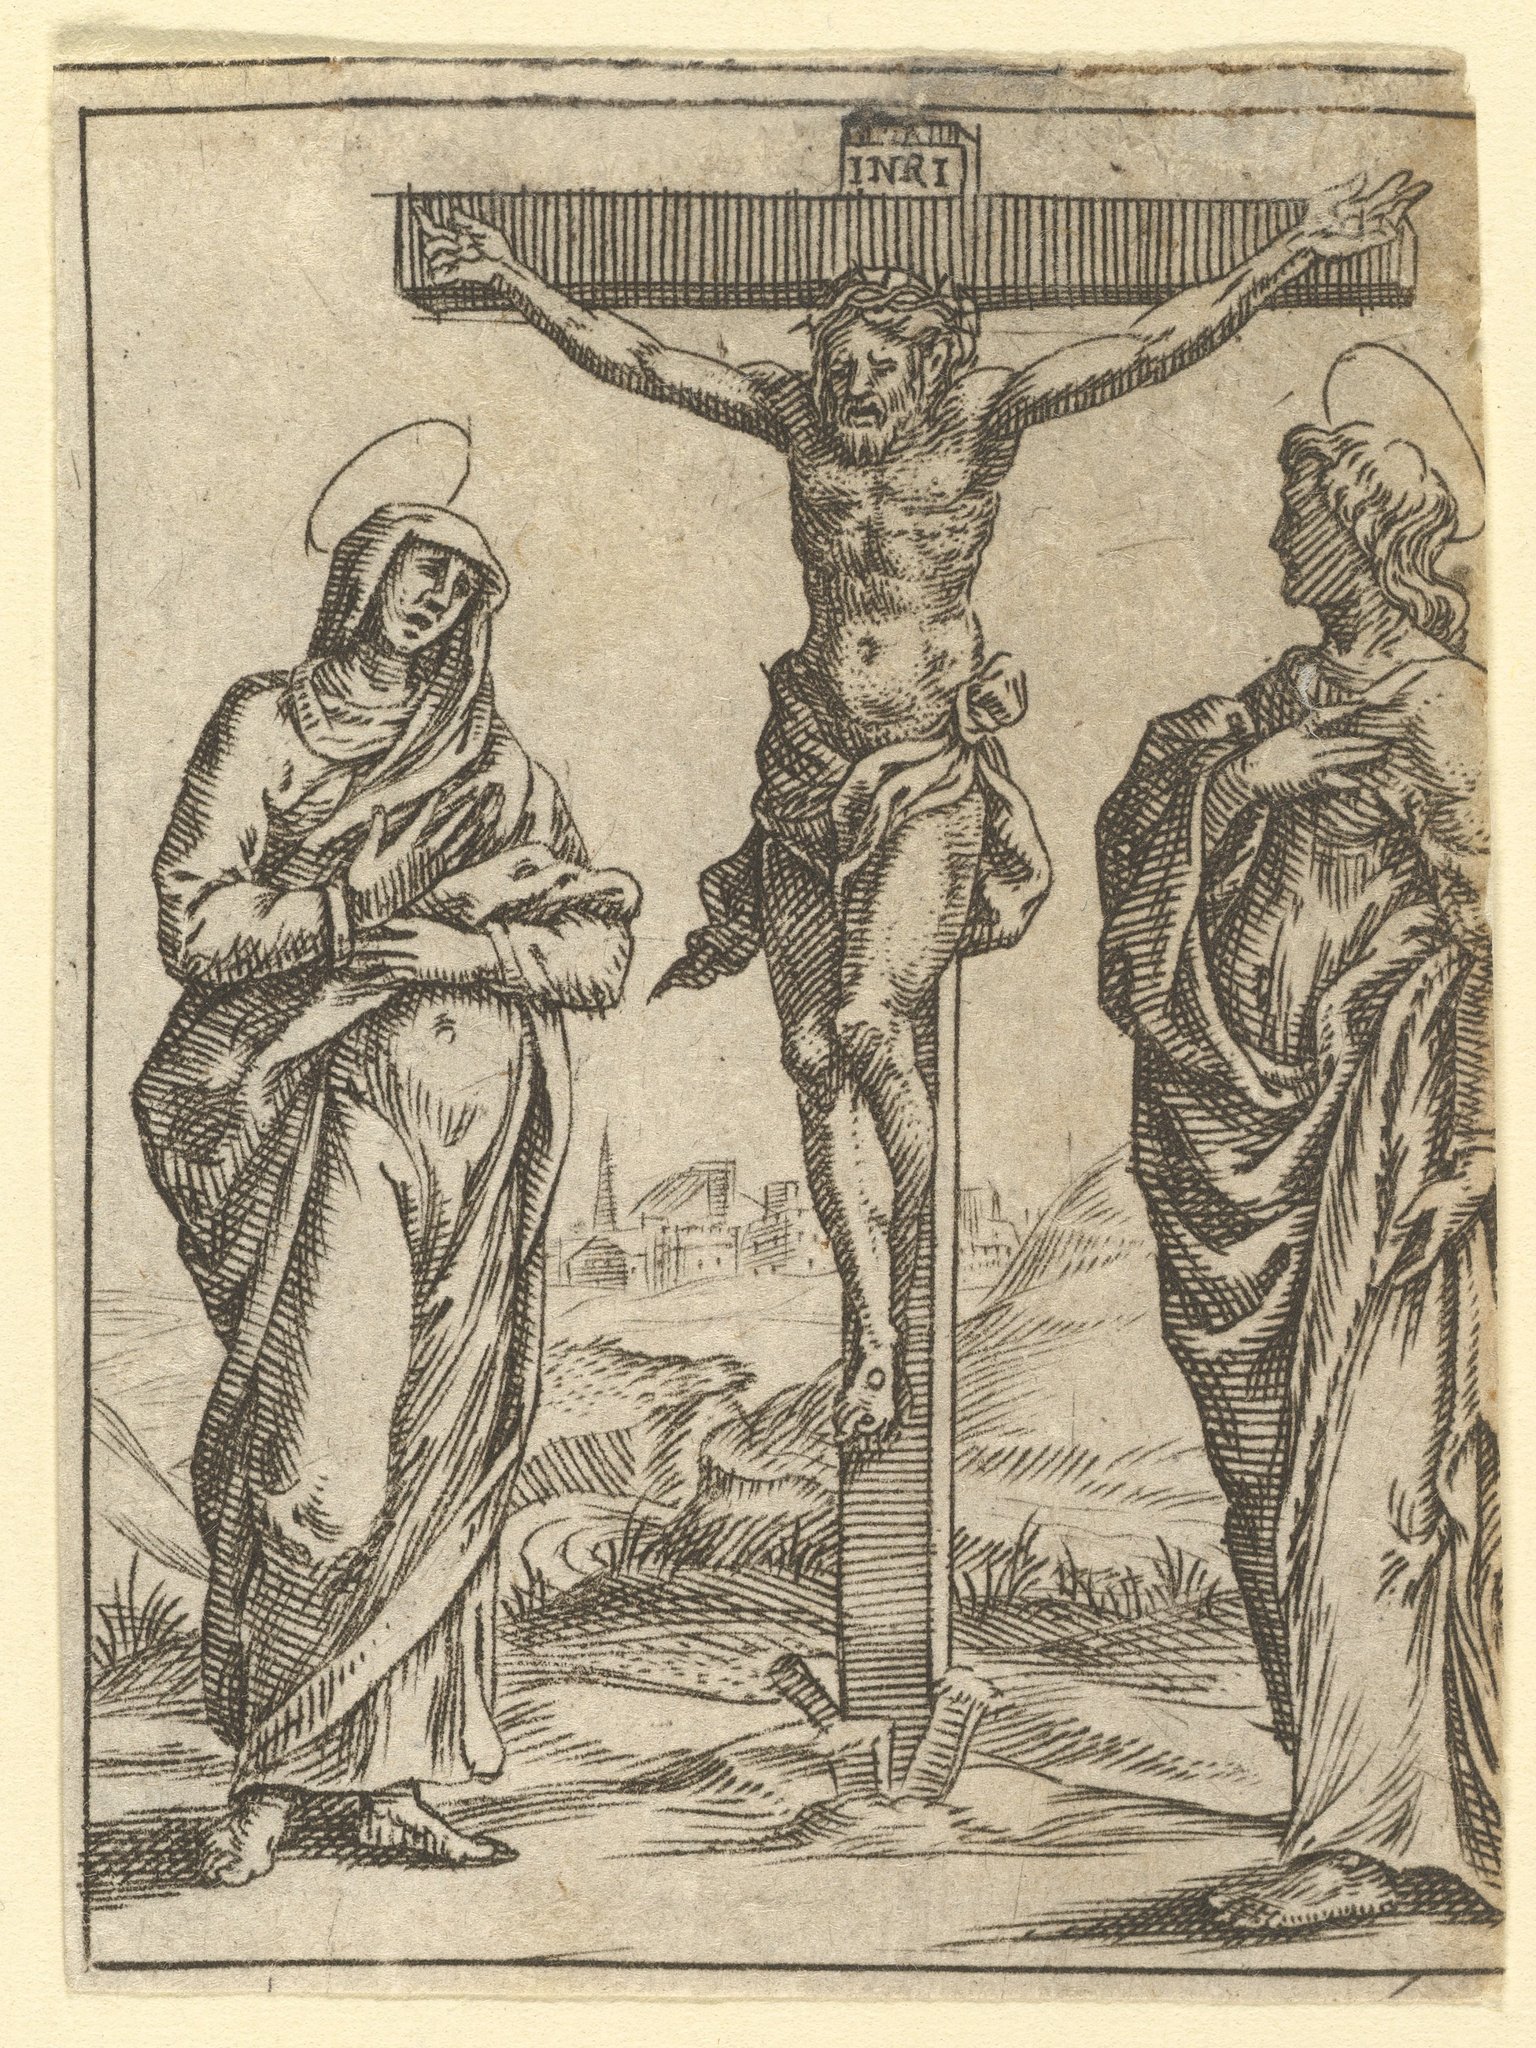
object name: print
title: The Virgin of Sorrows: The Crucifixion; one of nine surrounding compartments from the Virgin of Sorrows, now separated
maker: giorgio ghisi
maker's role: artist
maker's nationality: italian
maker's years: 1515-1582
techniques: engraving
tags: christ,virgin mary,cross,crucifixion